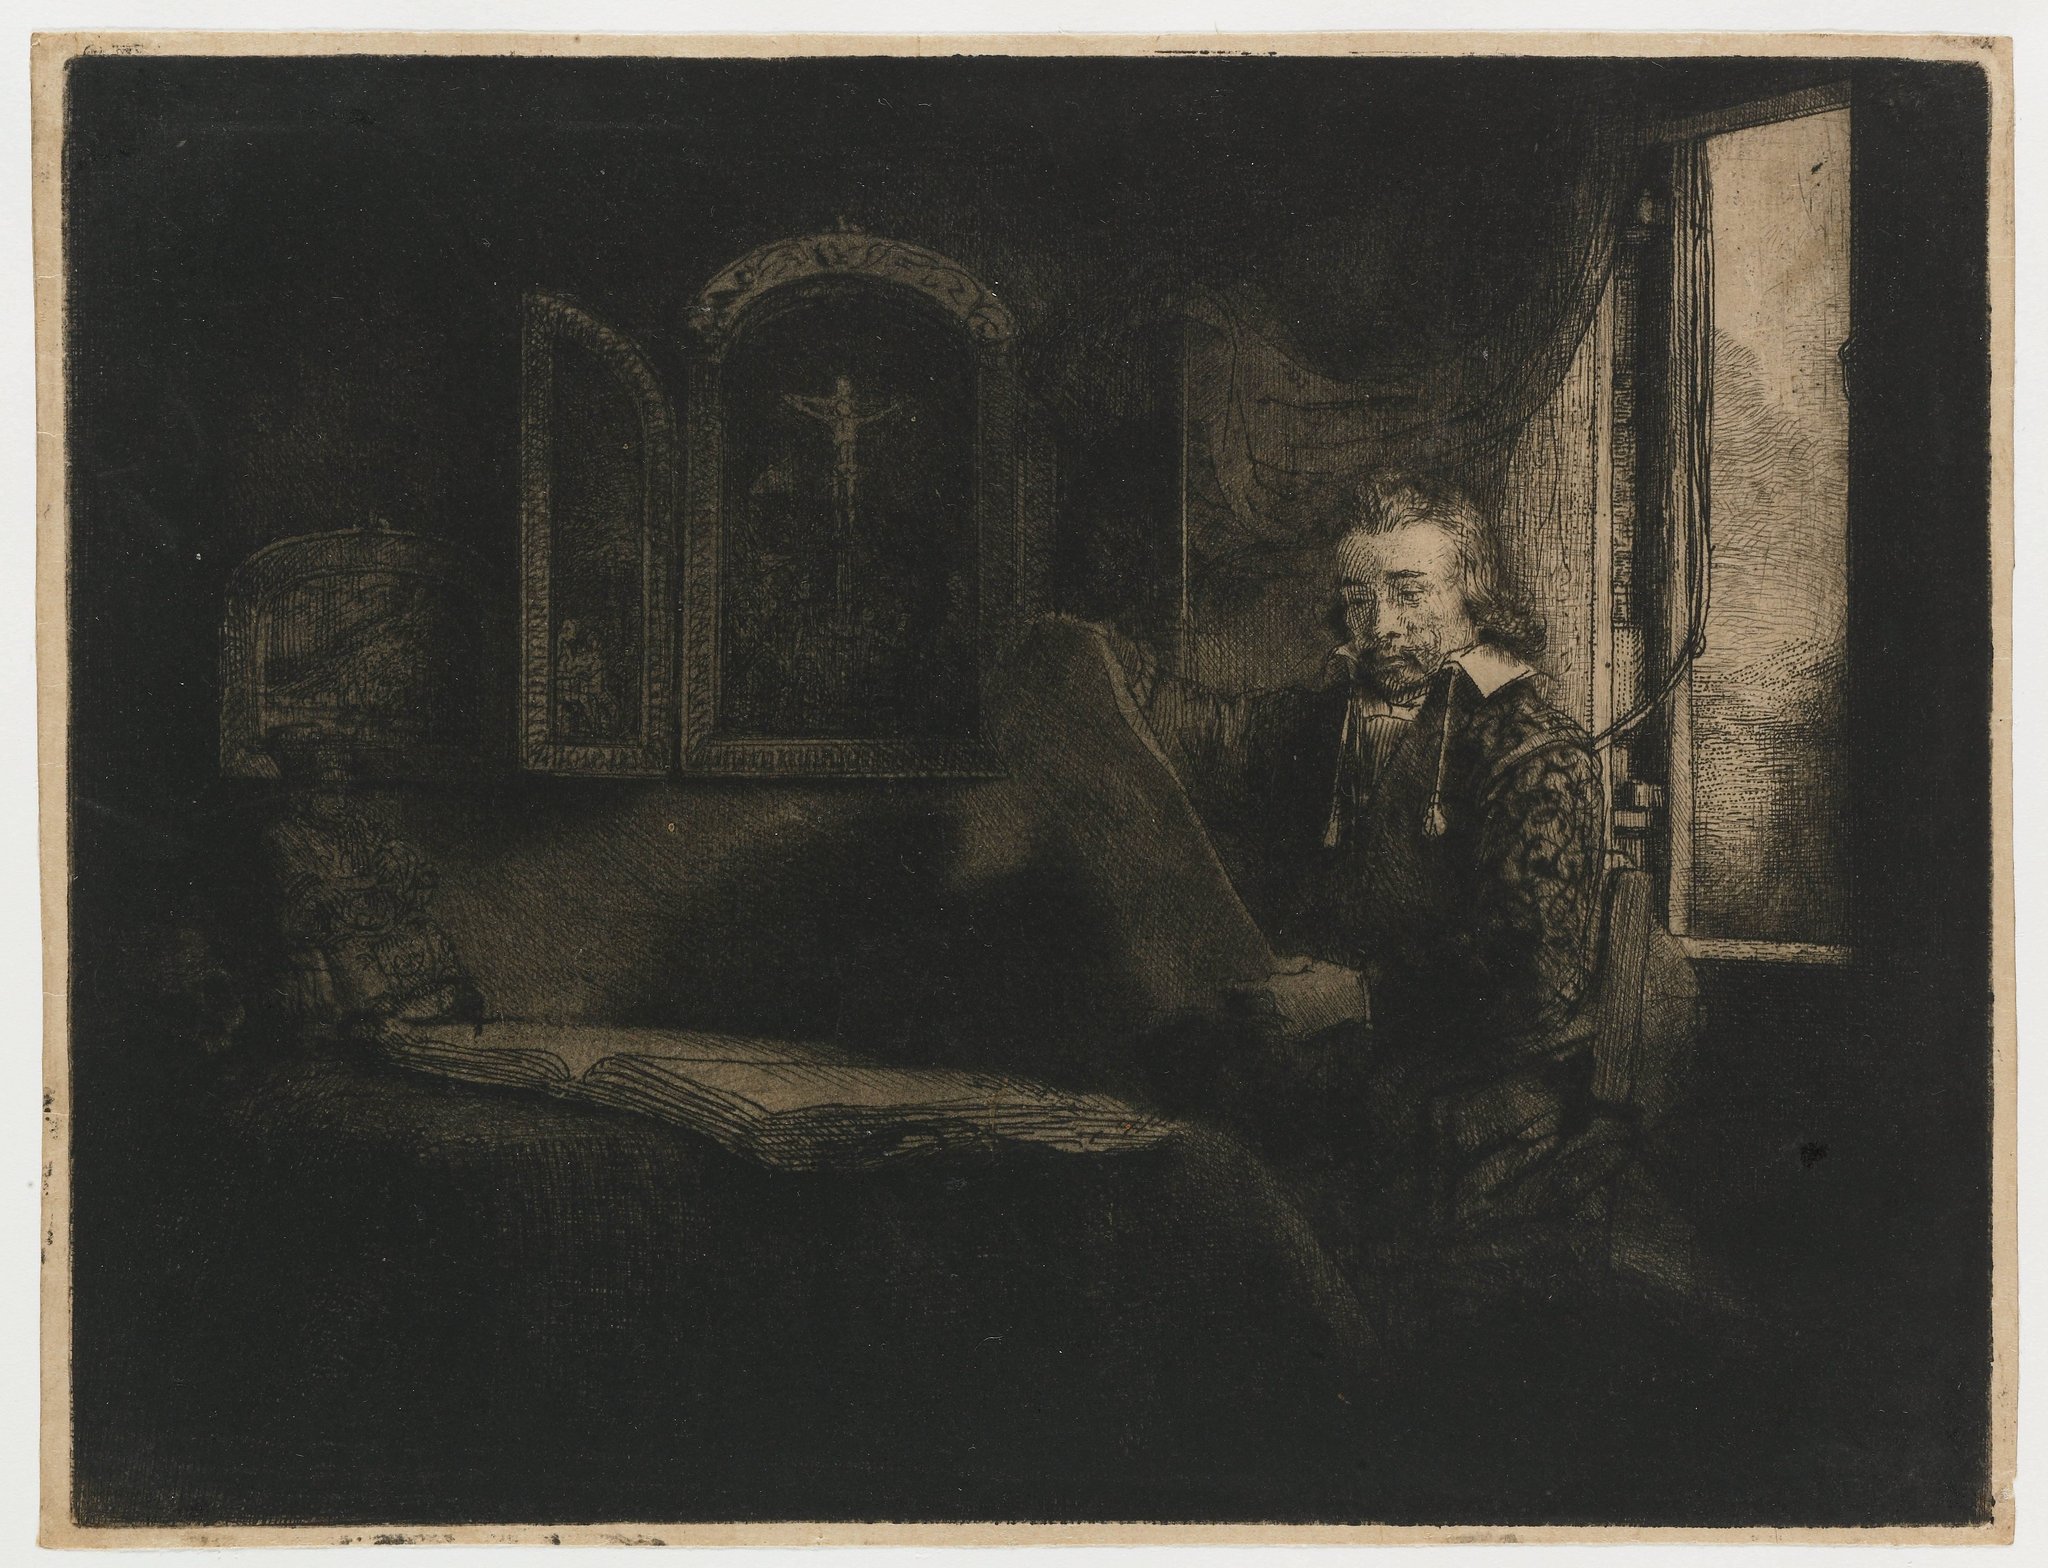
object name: print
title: Abraham Francen, apothecary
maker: rembrandt van rijn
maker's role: draughtsman, painter, print maker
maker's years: 1606-1669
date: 1657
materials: paper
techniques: drypoint, etching, intaglio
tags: abraham francen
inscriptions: collector's mark: Lugt 240, inscription: ‘Abraham Francen’